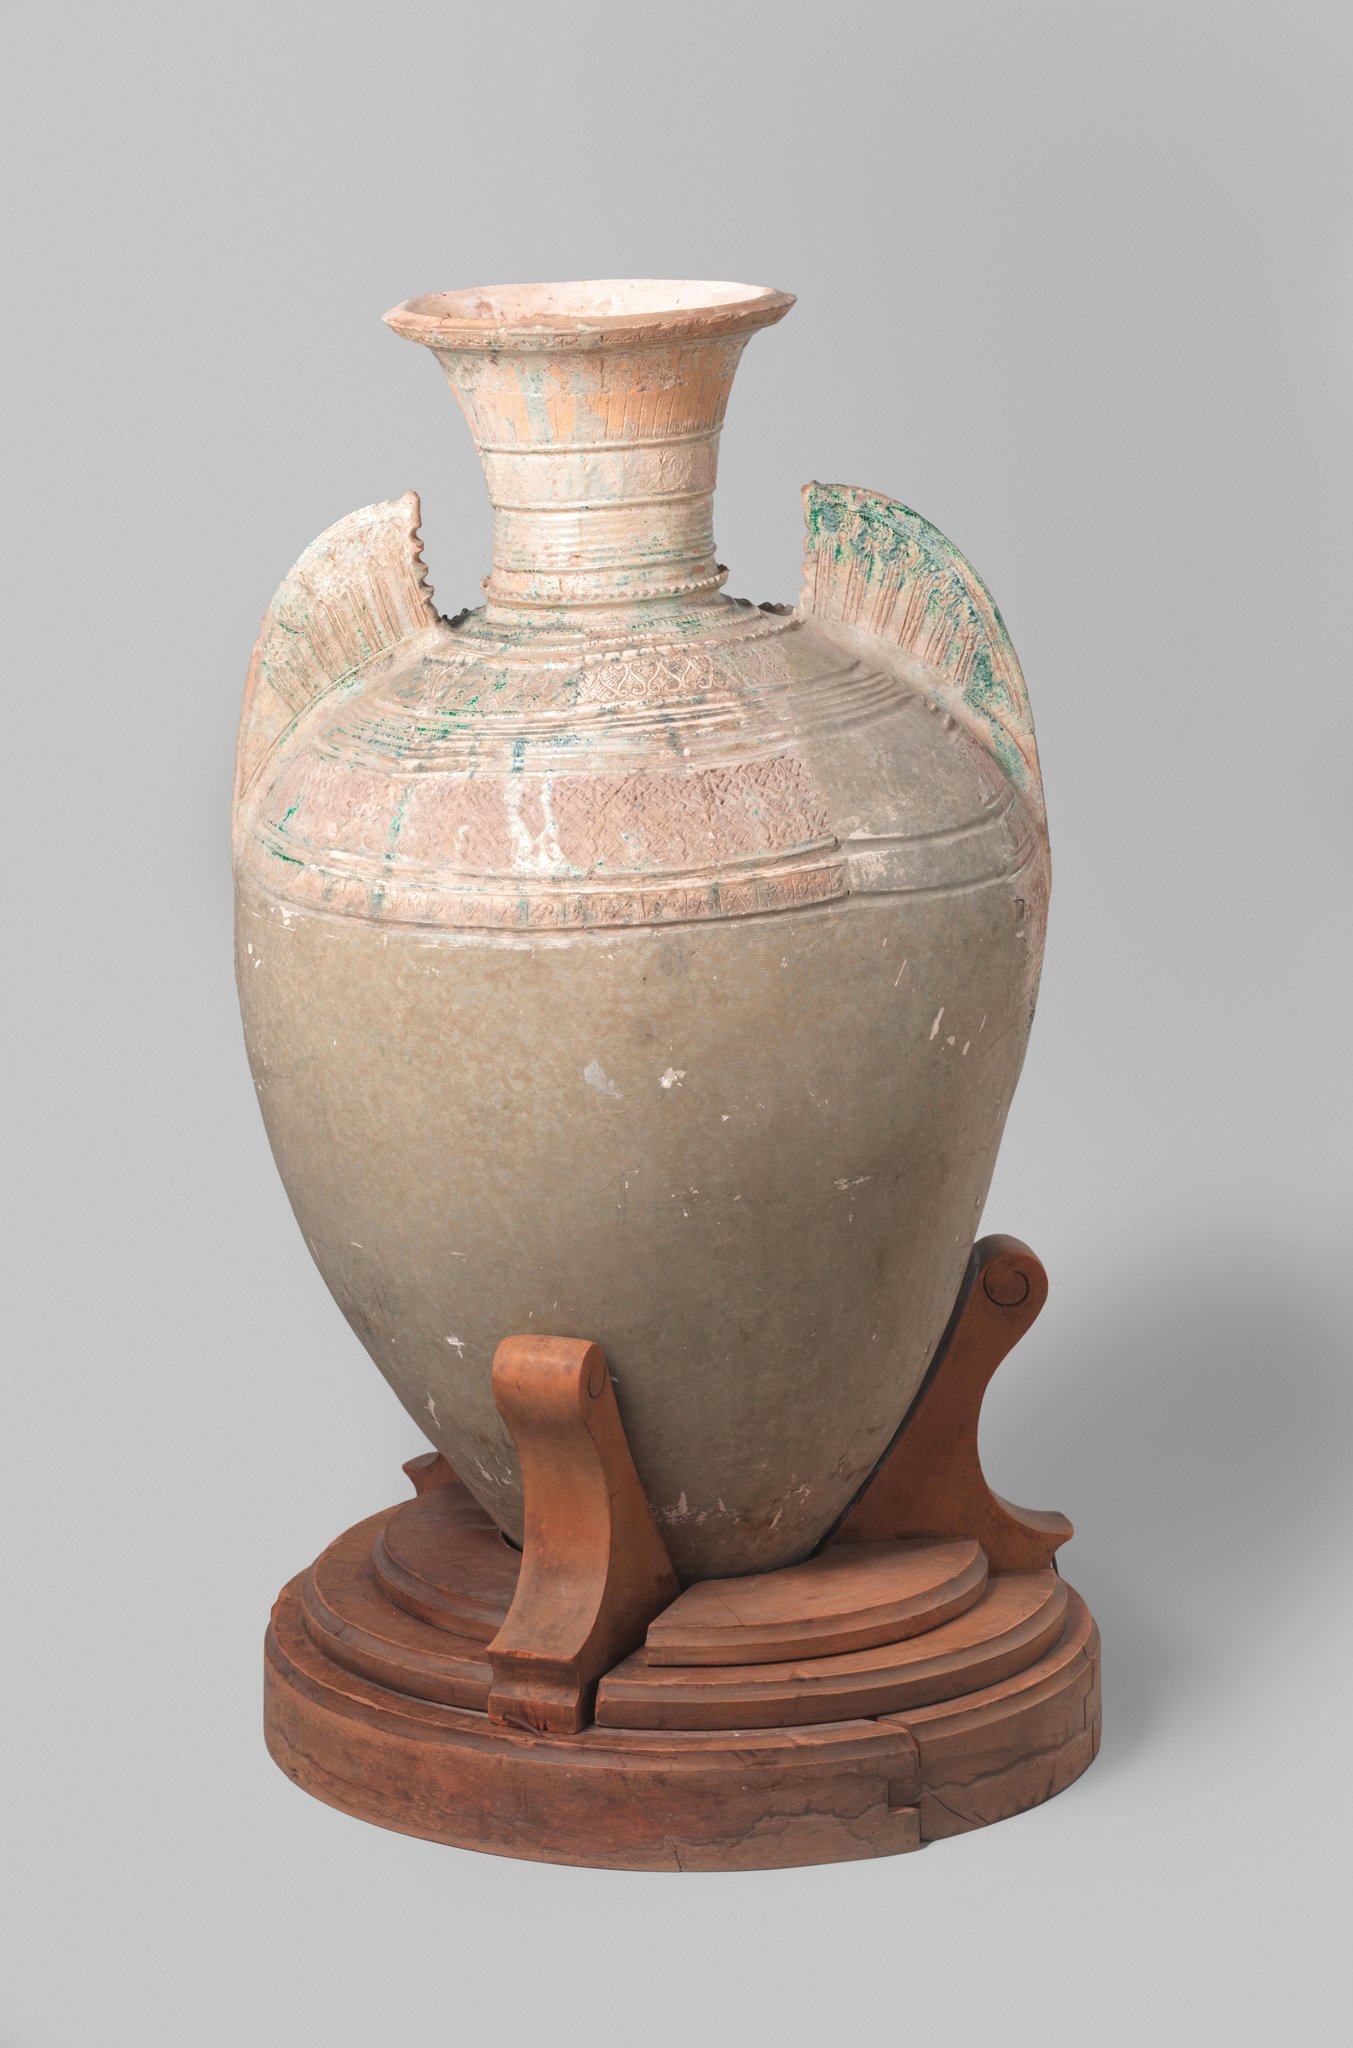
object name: vase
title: Vaas met eivormig lichaam met brede wijd uitstaande hals en twee hoge, gekartelde, platte oren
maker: Anonymous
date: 1400-1500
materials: earthenware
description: Fragment van een vaas gevonden te Málaga. De grondvorm was: een eivormig lichaam met brede wijd uitstaande hals en twee hoge, gekartelde, platte oren. Op grijs witte scherf, waarschijnlijk geheel groen geglazuurd. De beide stukken zijn van verschillende exemplaren afkomstig en hebben slechts de grondvorm gemeen. Het in zones ingedeeld decor vertoont enkele afwijkingen in de combinatie en de details. De versiering is in de weke aarde gegrift en bestaat uit Arabische inscripties, palmetten, vlechtbanden, ringen en balustervormig gearrangeerde kleine bloeiende bomen. Deze laatste komen slechts op dat fragment voor waarvan het deel onderaan de vaas bewaard is gebleven. Spaans-Moors. Glazuur overal sterk verweerd waardoor plaatselijk metaalglanzen ontstaan zijn.